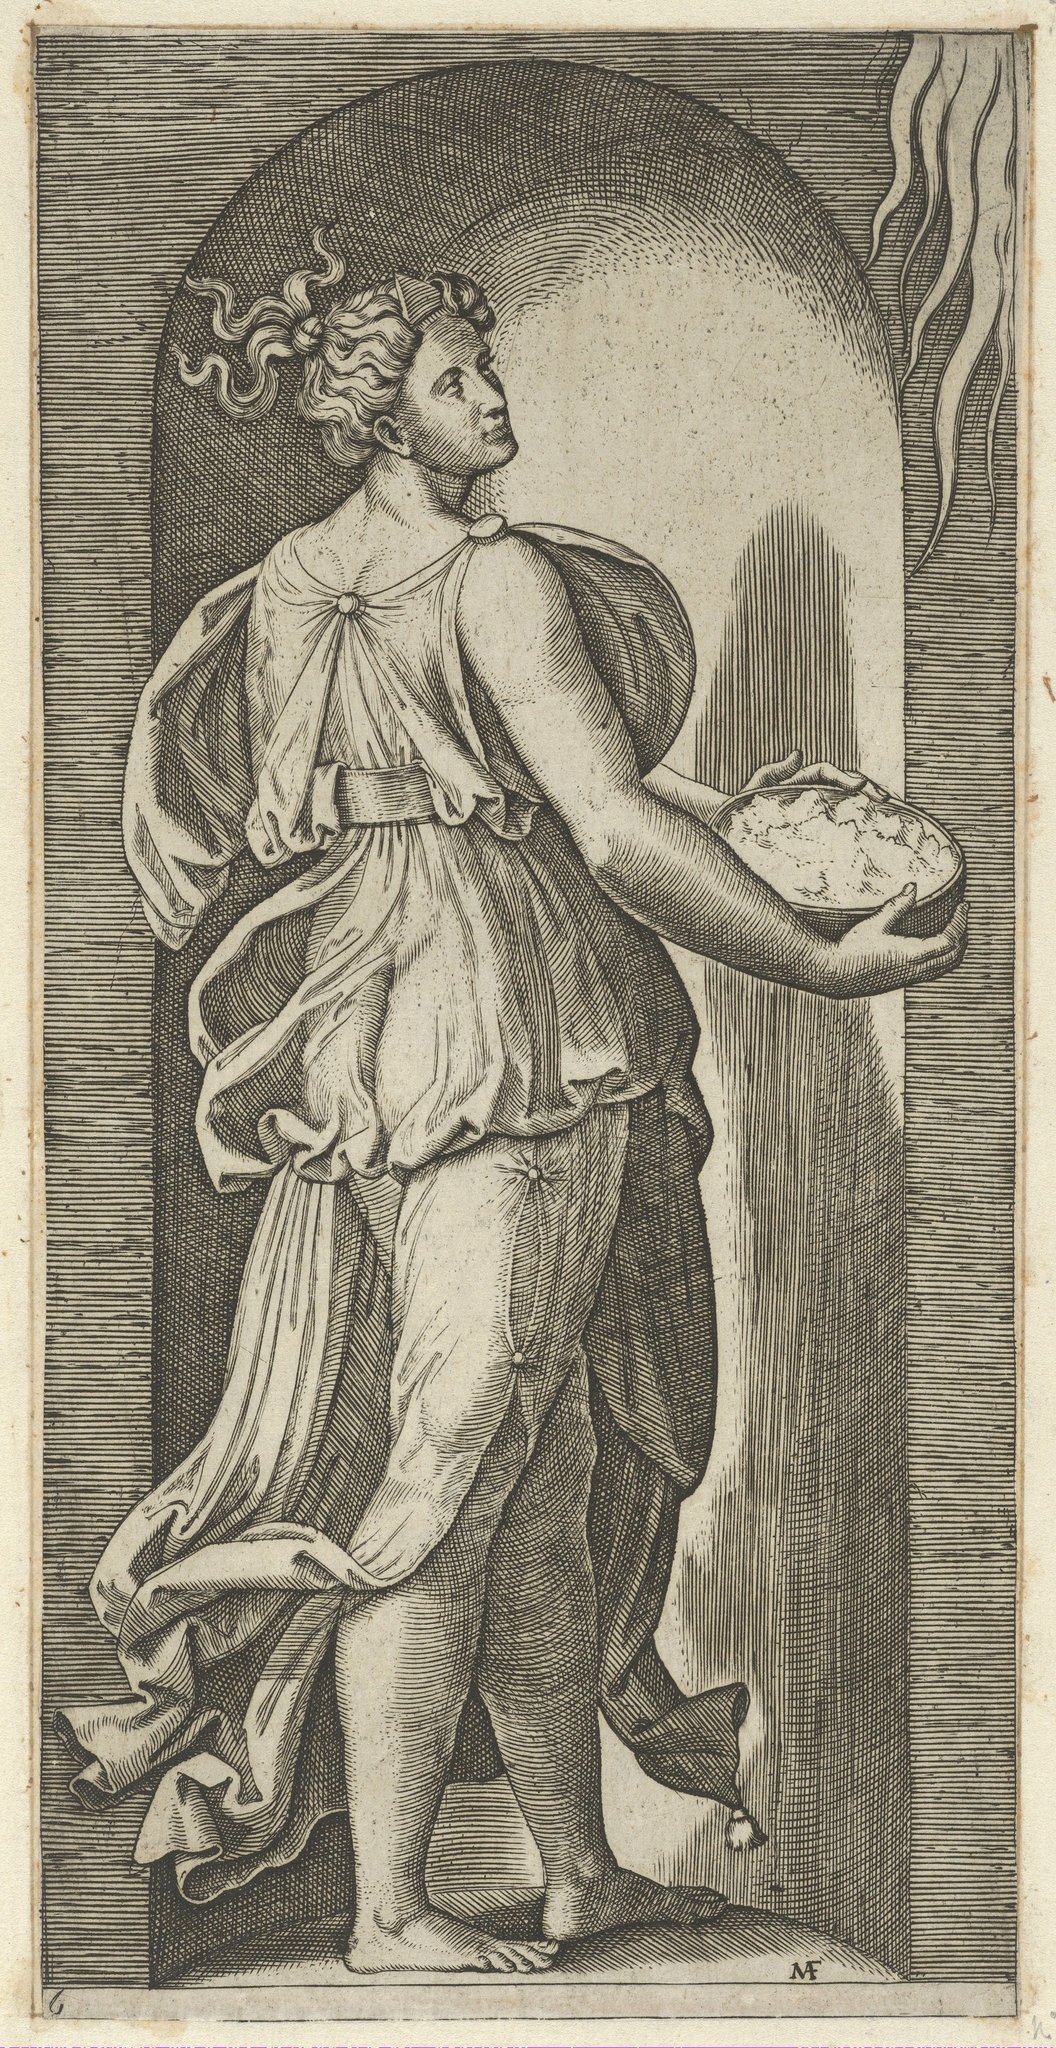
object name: print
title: Hope personified as a woman standing in a niche facing right, holding a container of unleavened bread in both hands, from "The Virtues"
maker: marcantonio raimondi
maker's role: artist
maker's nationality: italian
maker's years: 1475-1534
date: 1515-1525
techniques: engraving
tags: bread,women